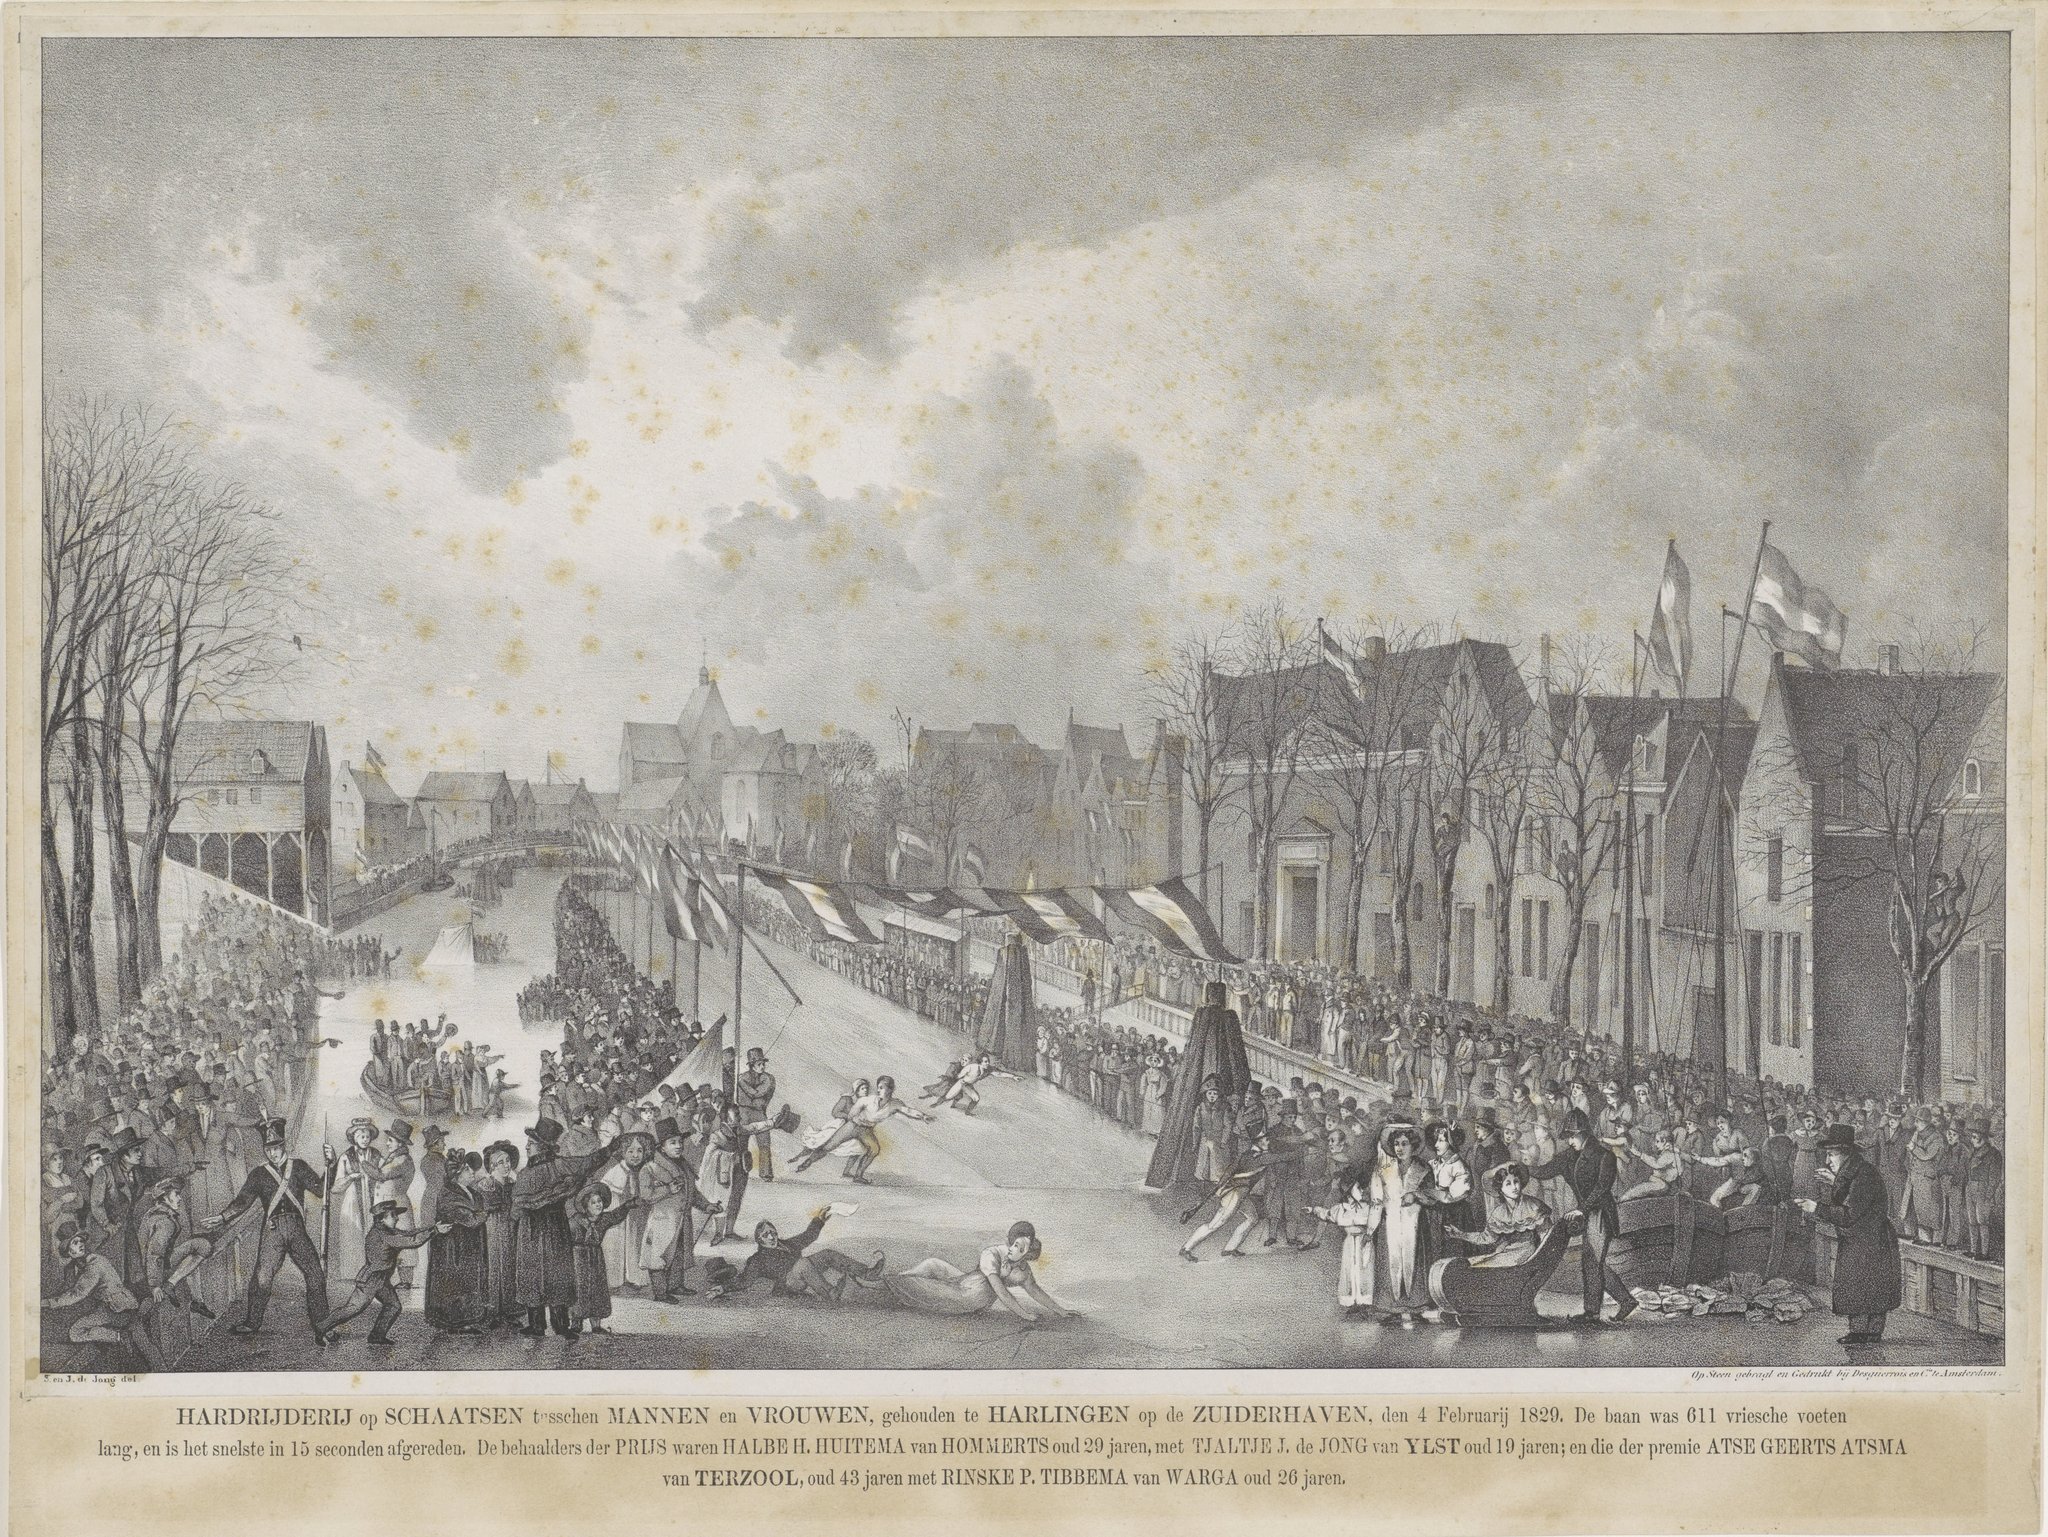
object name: print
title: Hardrijderij op Schaatsen tusschen Mannen en Vrouwen, gehouden te Harlingen op de Zuiderhaven, den 4 Februarij 1829 (...) behaalders der Prijs waren Halbe H. Huitema van Hommerts oud 29 jaren, met Tjaltje J. de Jong van Ylst (...) Atse Geerts Atsma van Terzool (...) met Rinkse P. Tibbema van Warga (...)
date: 1829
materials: paper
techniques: lithograph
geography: netherlands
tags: skates (winter sports), harlingen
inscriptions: collector's mark: Lugt 2228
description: Schaatswedstrijd voor mannen en vrouwen in paren gehouden op het ijs van de Zuiderhaven te Harlingen, 4 februari 1829. Twee stellen rijden naar de finish. Op de voorgrond zijn een man en een vrouw op het ijs gevallen. Op het ijs en op de kades grote groepen toeschouwers. Langs de baan masten met vlaggen. Geplakt op een blad met een drieregelig onderschrift.